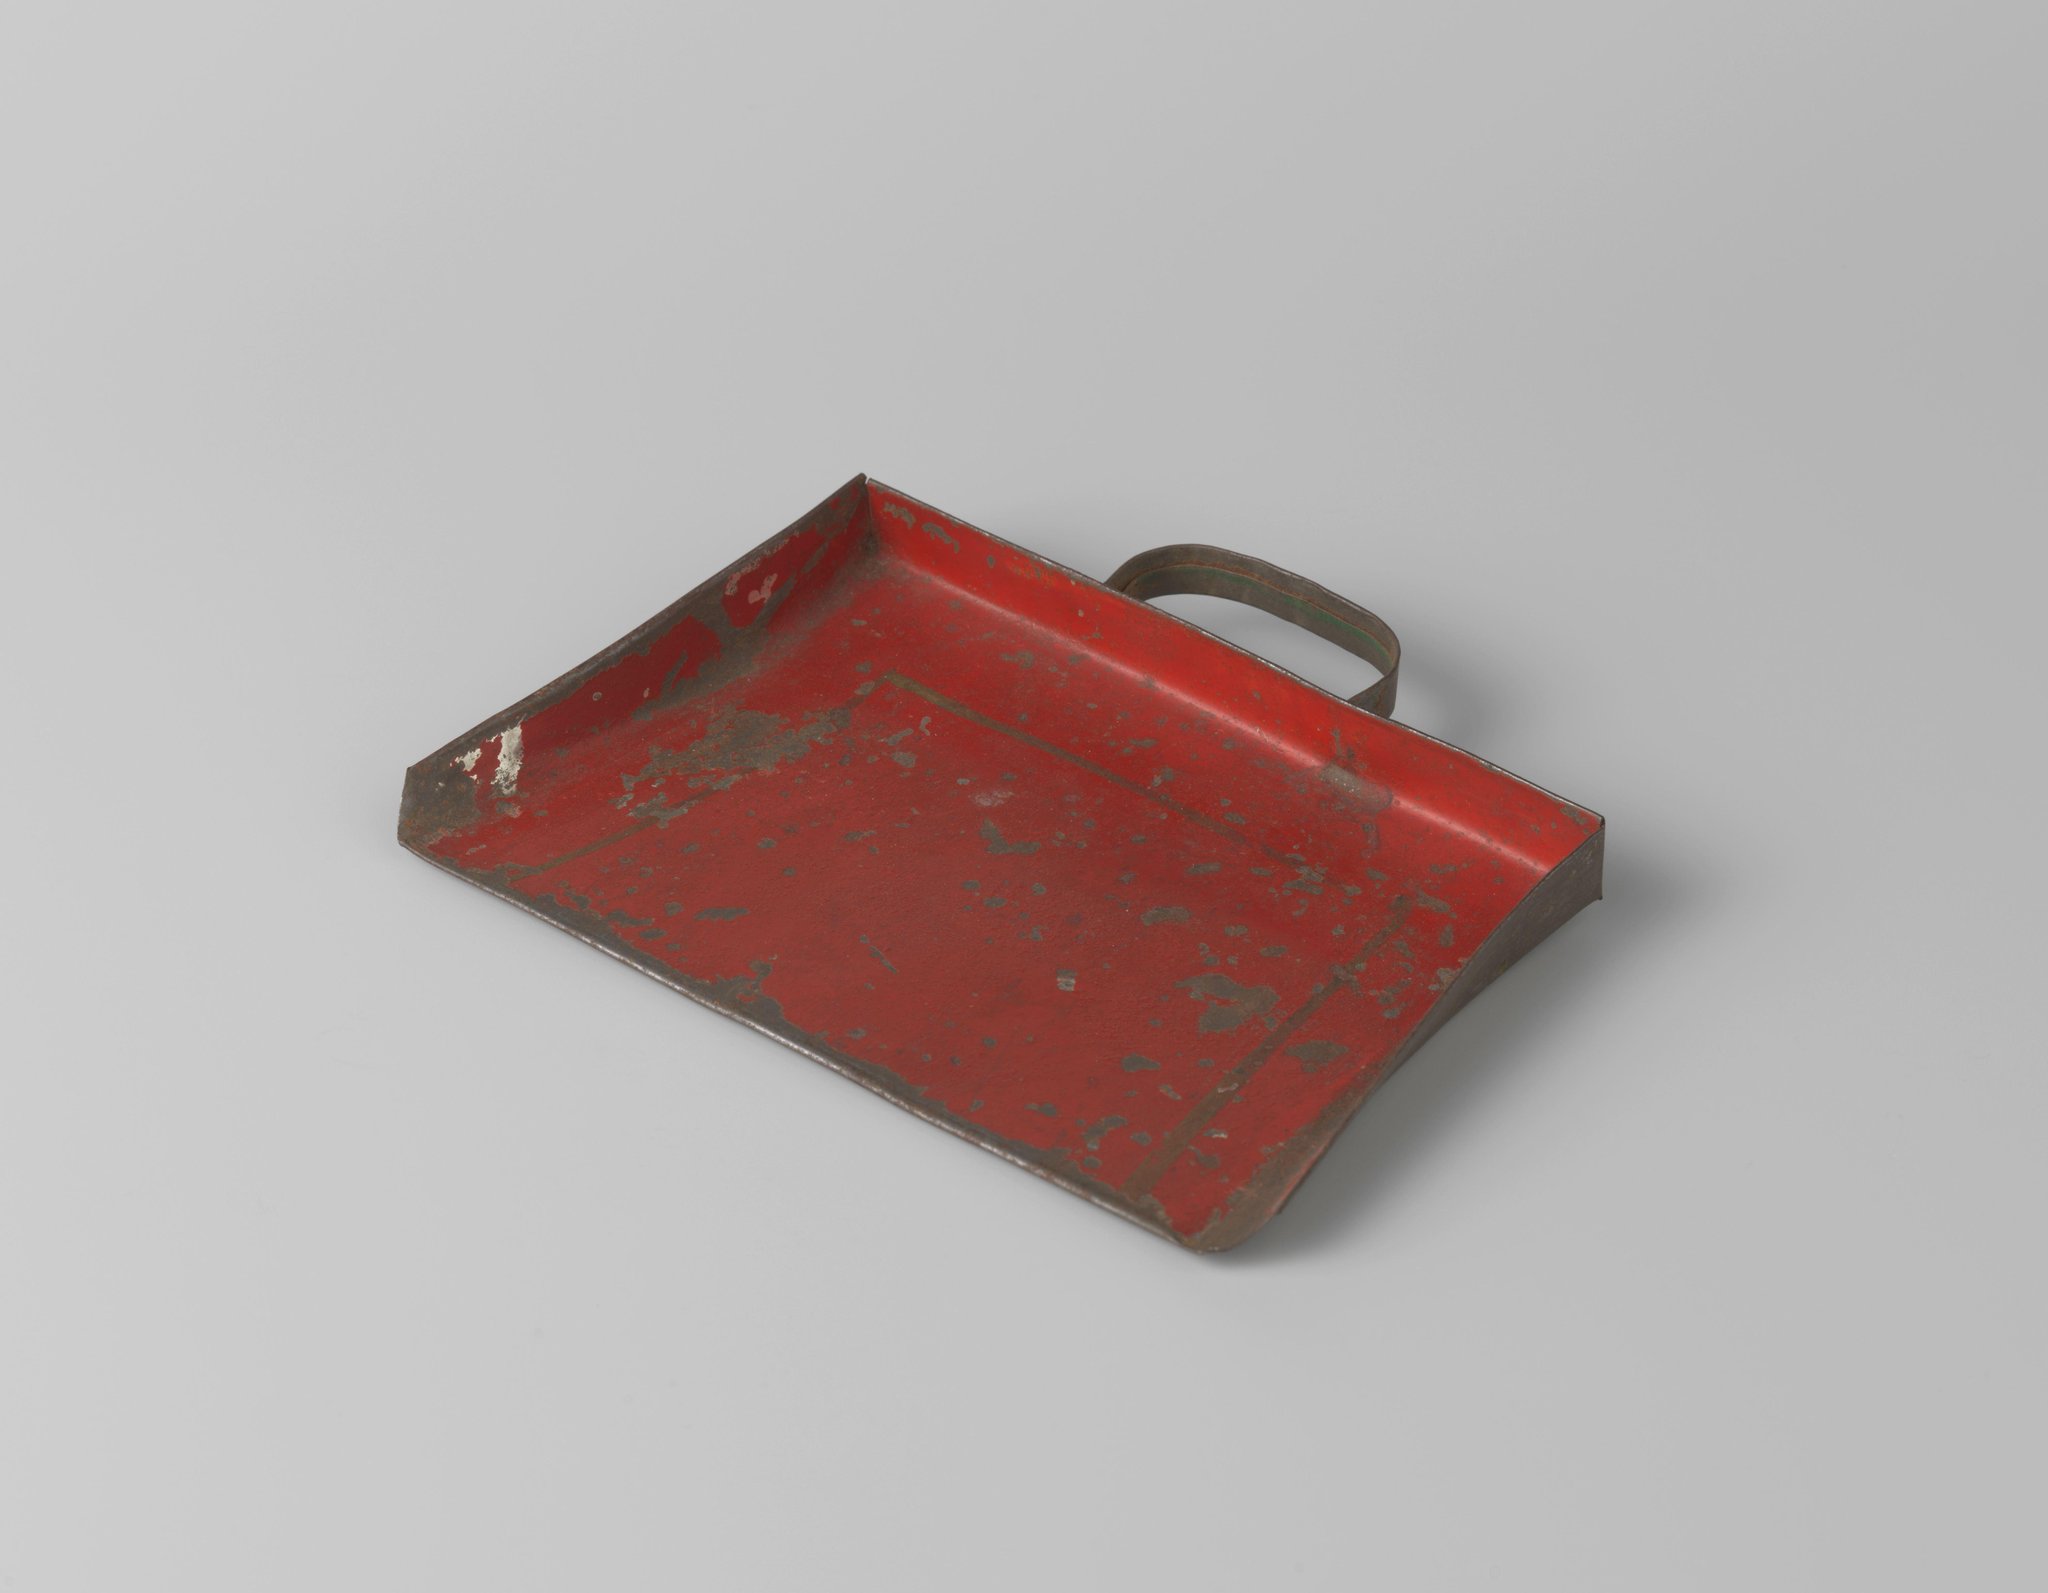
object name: dustpan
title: Poppenstofblik roodgelakt met verguld biesje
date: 1915-1925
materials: paint, metal